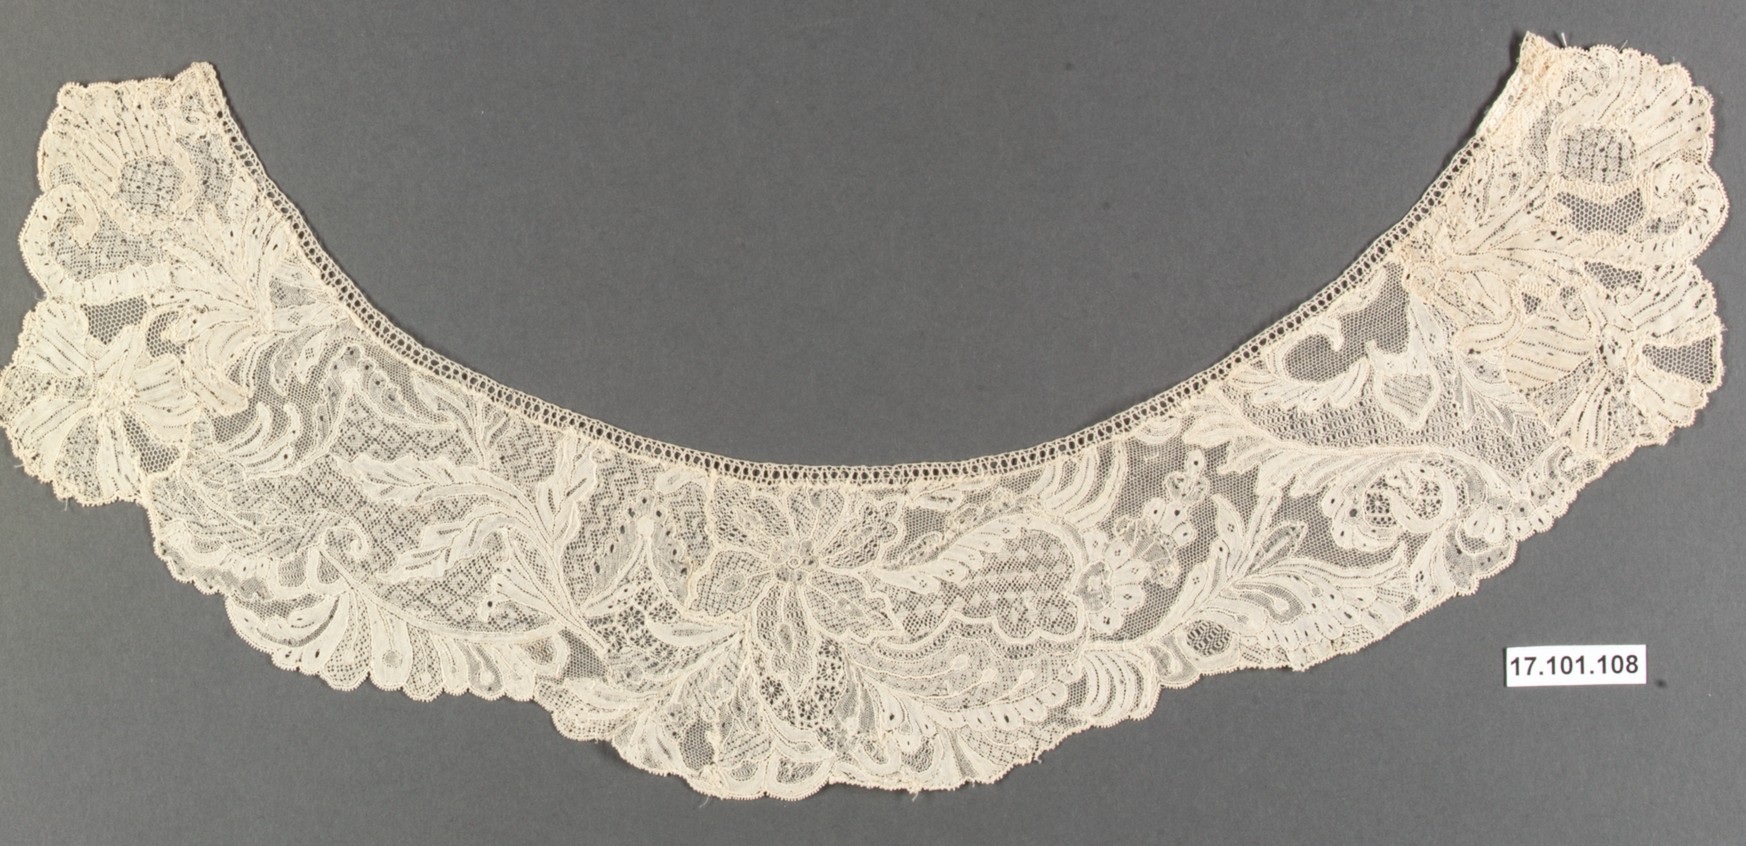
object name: collar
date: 1701-1800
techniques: lace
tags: flowers